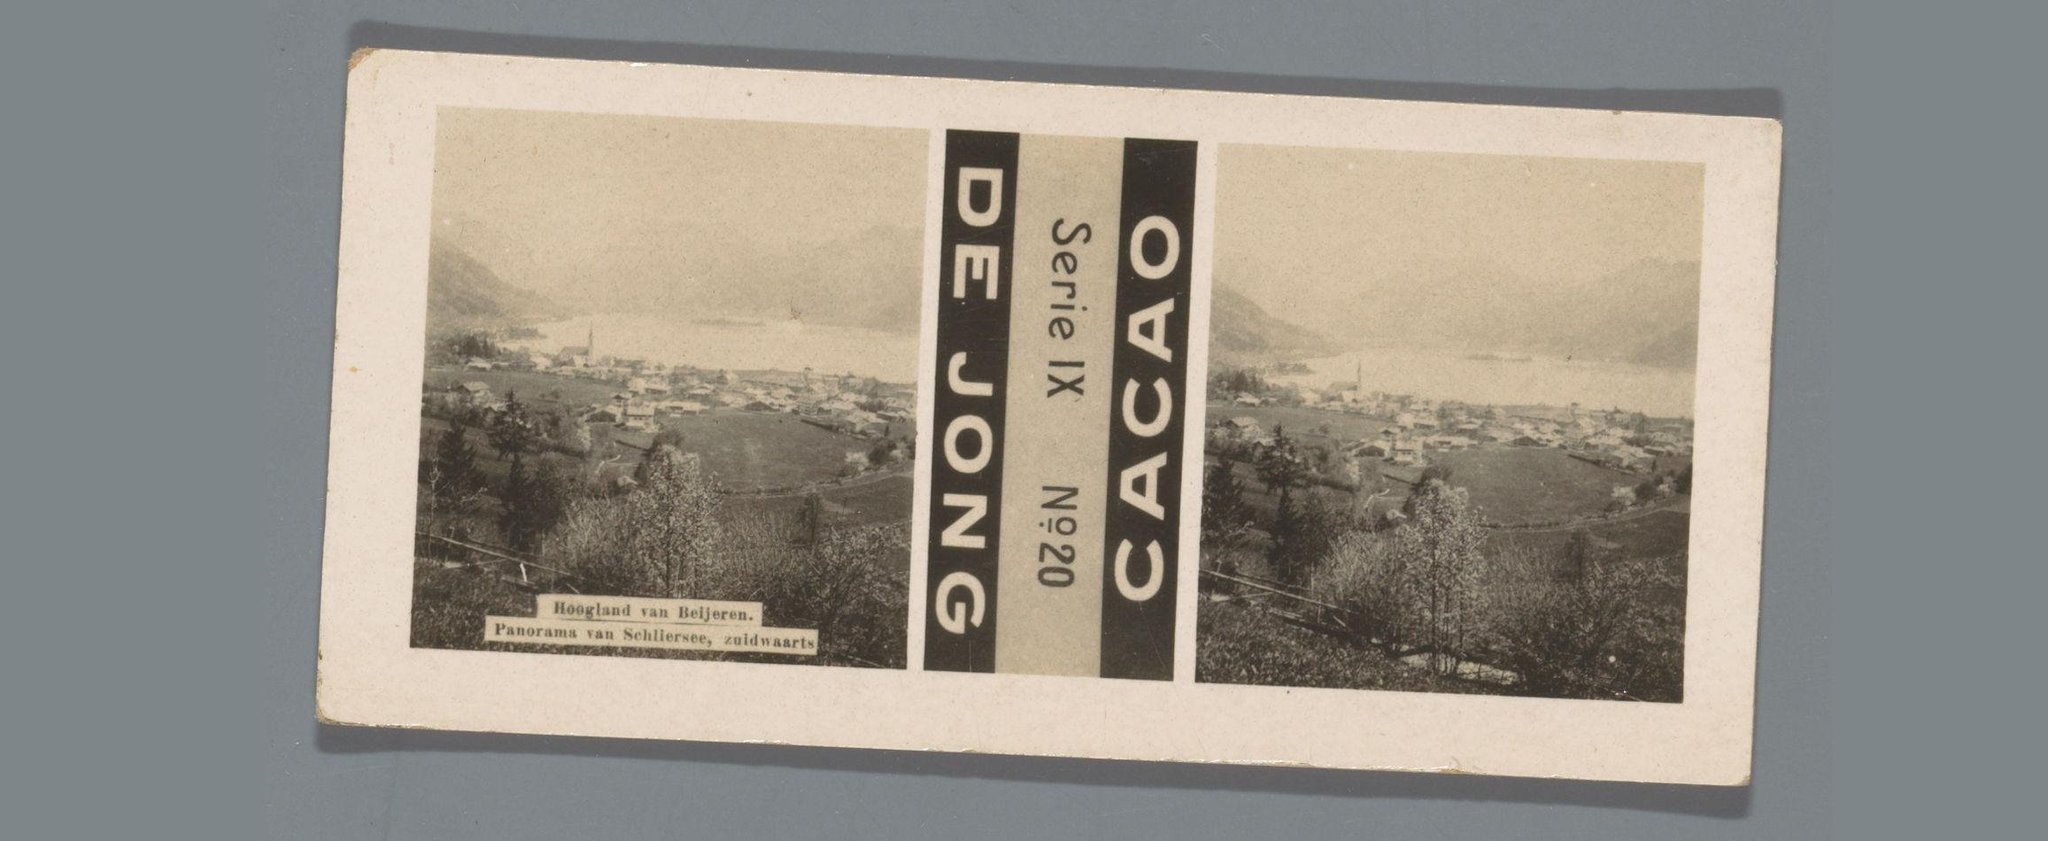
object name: stereograph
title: Gezicht op de Schliersee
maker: Anonymous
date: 1900-1910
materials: cardboard, photographic support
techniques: gelatin silver print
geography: wormerveer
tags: lake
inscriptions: number: ‘Serie IX No. 20’, inscription: ‘De Jong Cacao’